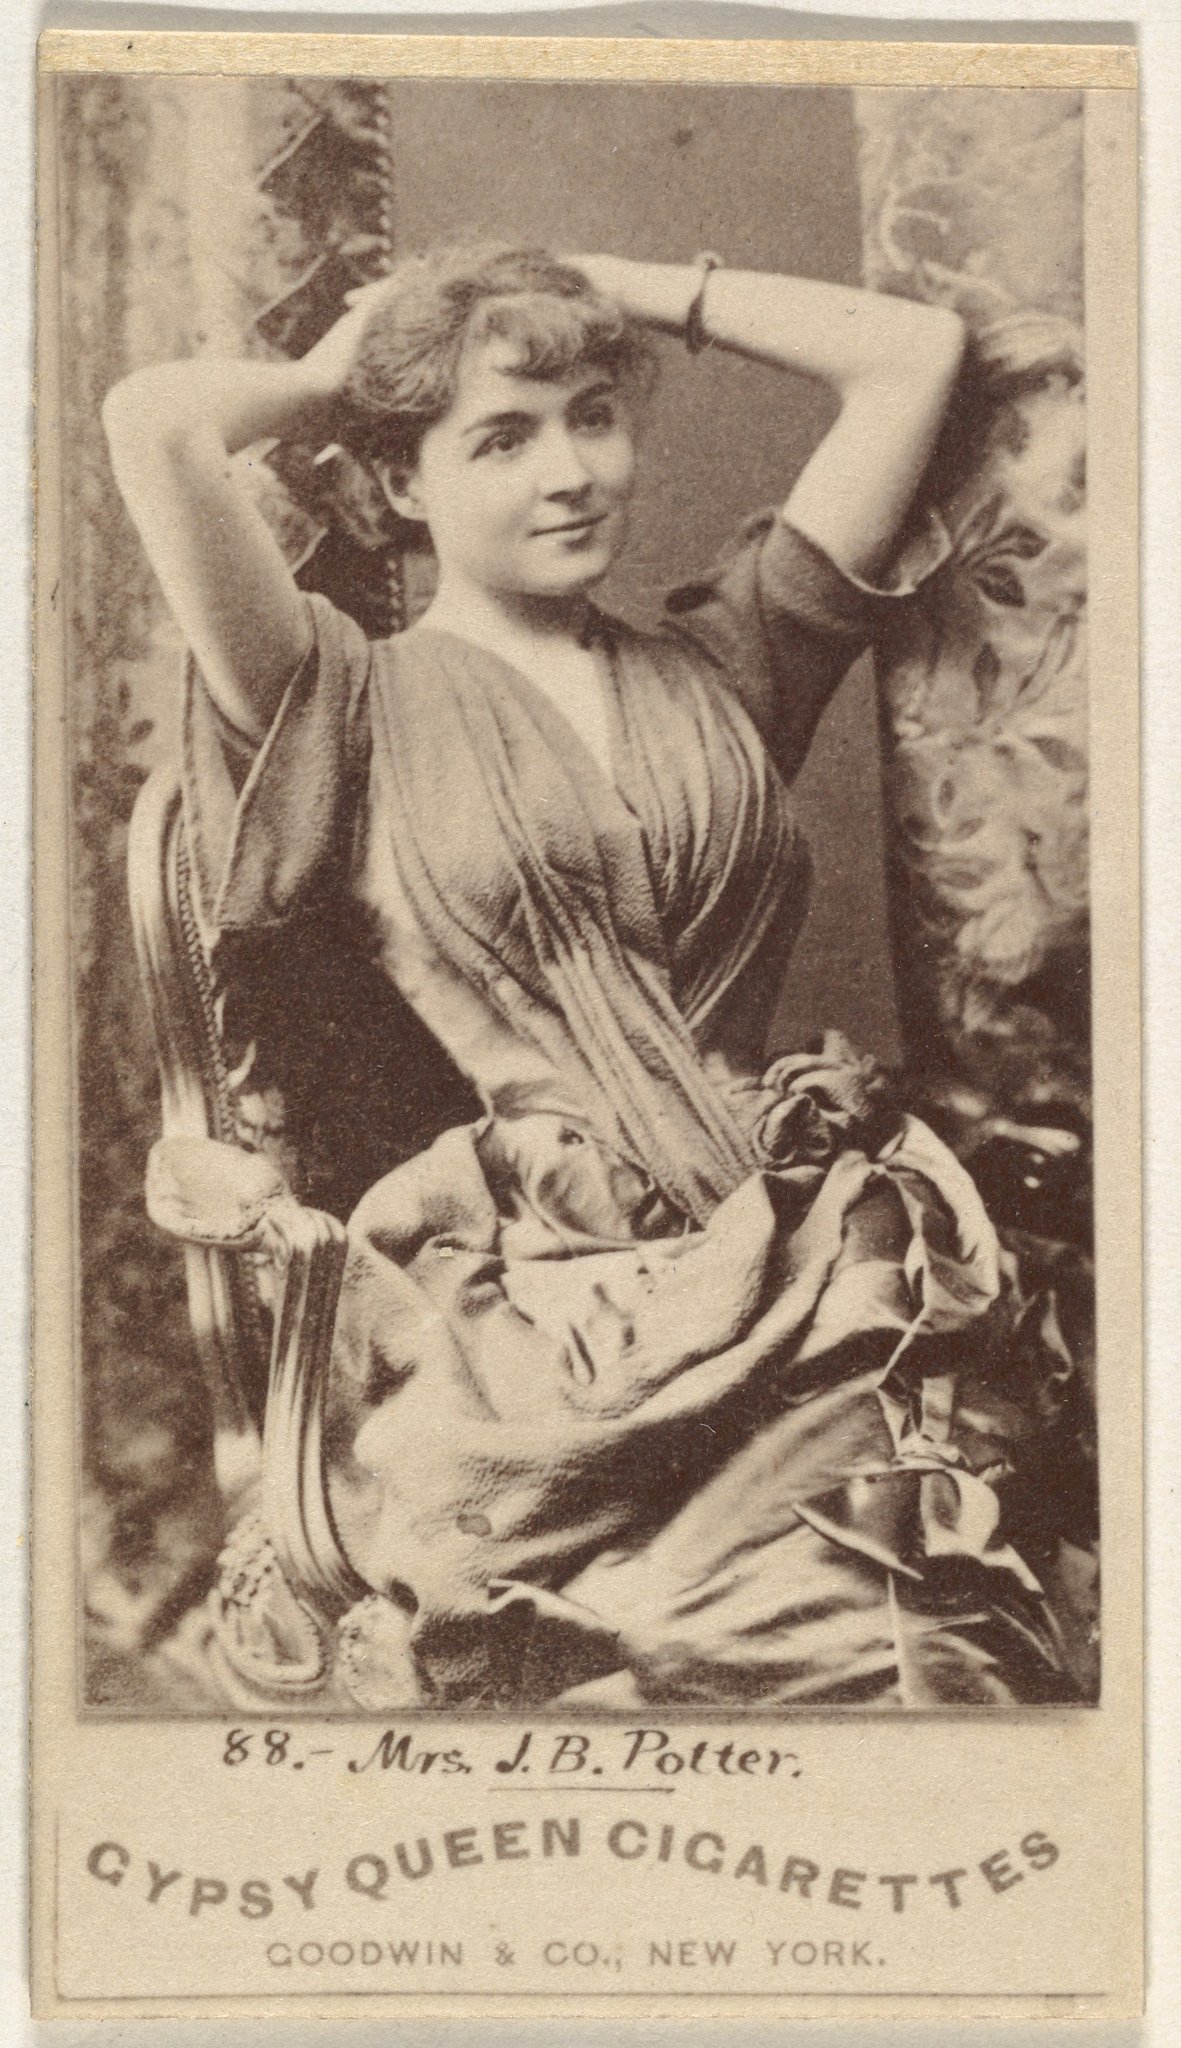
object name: photograph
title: Mrs. J.B. Potter, from the Actors and Actresses series (N171) for Gypsy Queen Cigarettes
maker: goodwin & company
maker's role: publisher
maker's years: 1850-1950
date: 1886-1890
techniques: albumen silver print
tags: portraits,women,actresses